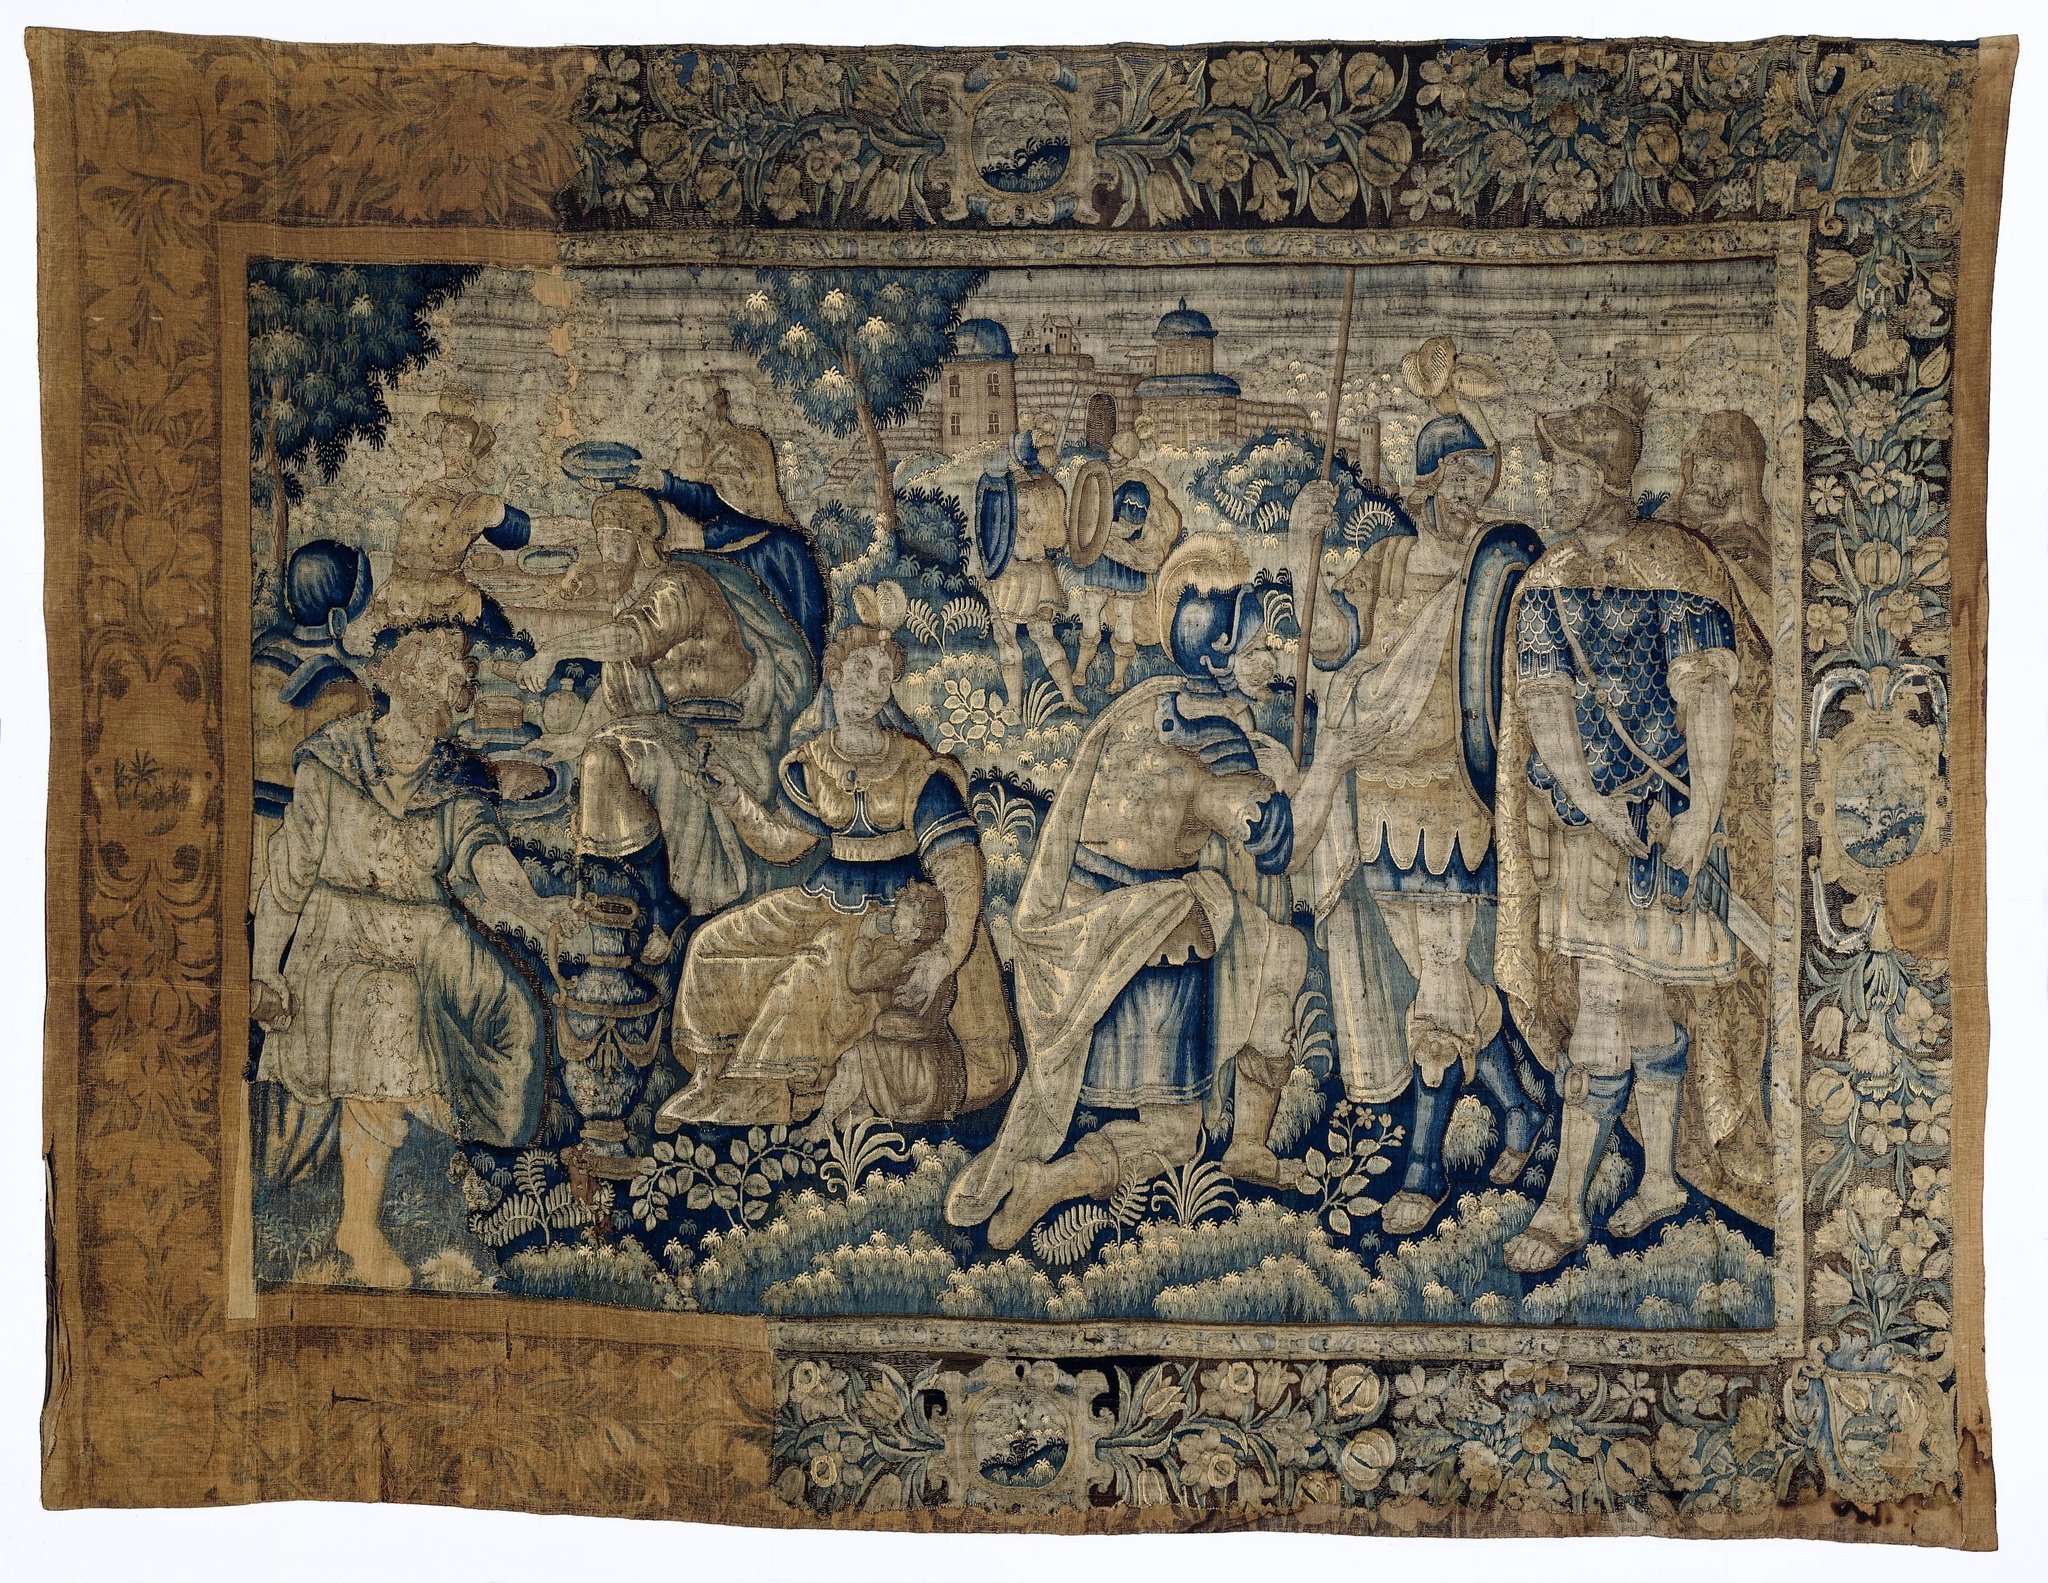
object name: tapestry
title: De geschiedenis van Alexander de Grote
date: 1625-1650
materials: silk, wool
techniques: tapestry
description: Wandtapijt met Darius voor Alexander, uit een serie met de geschiedenis van Alexander de Grote. Slechte staat, er ontbreken grote delen, deels ingeschilderd.